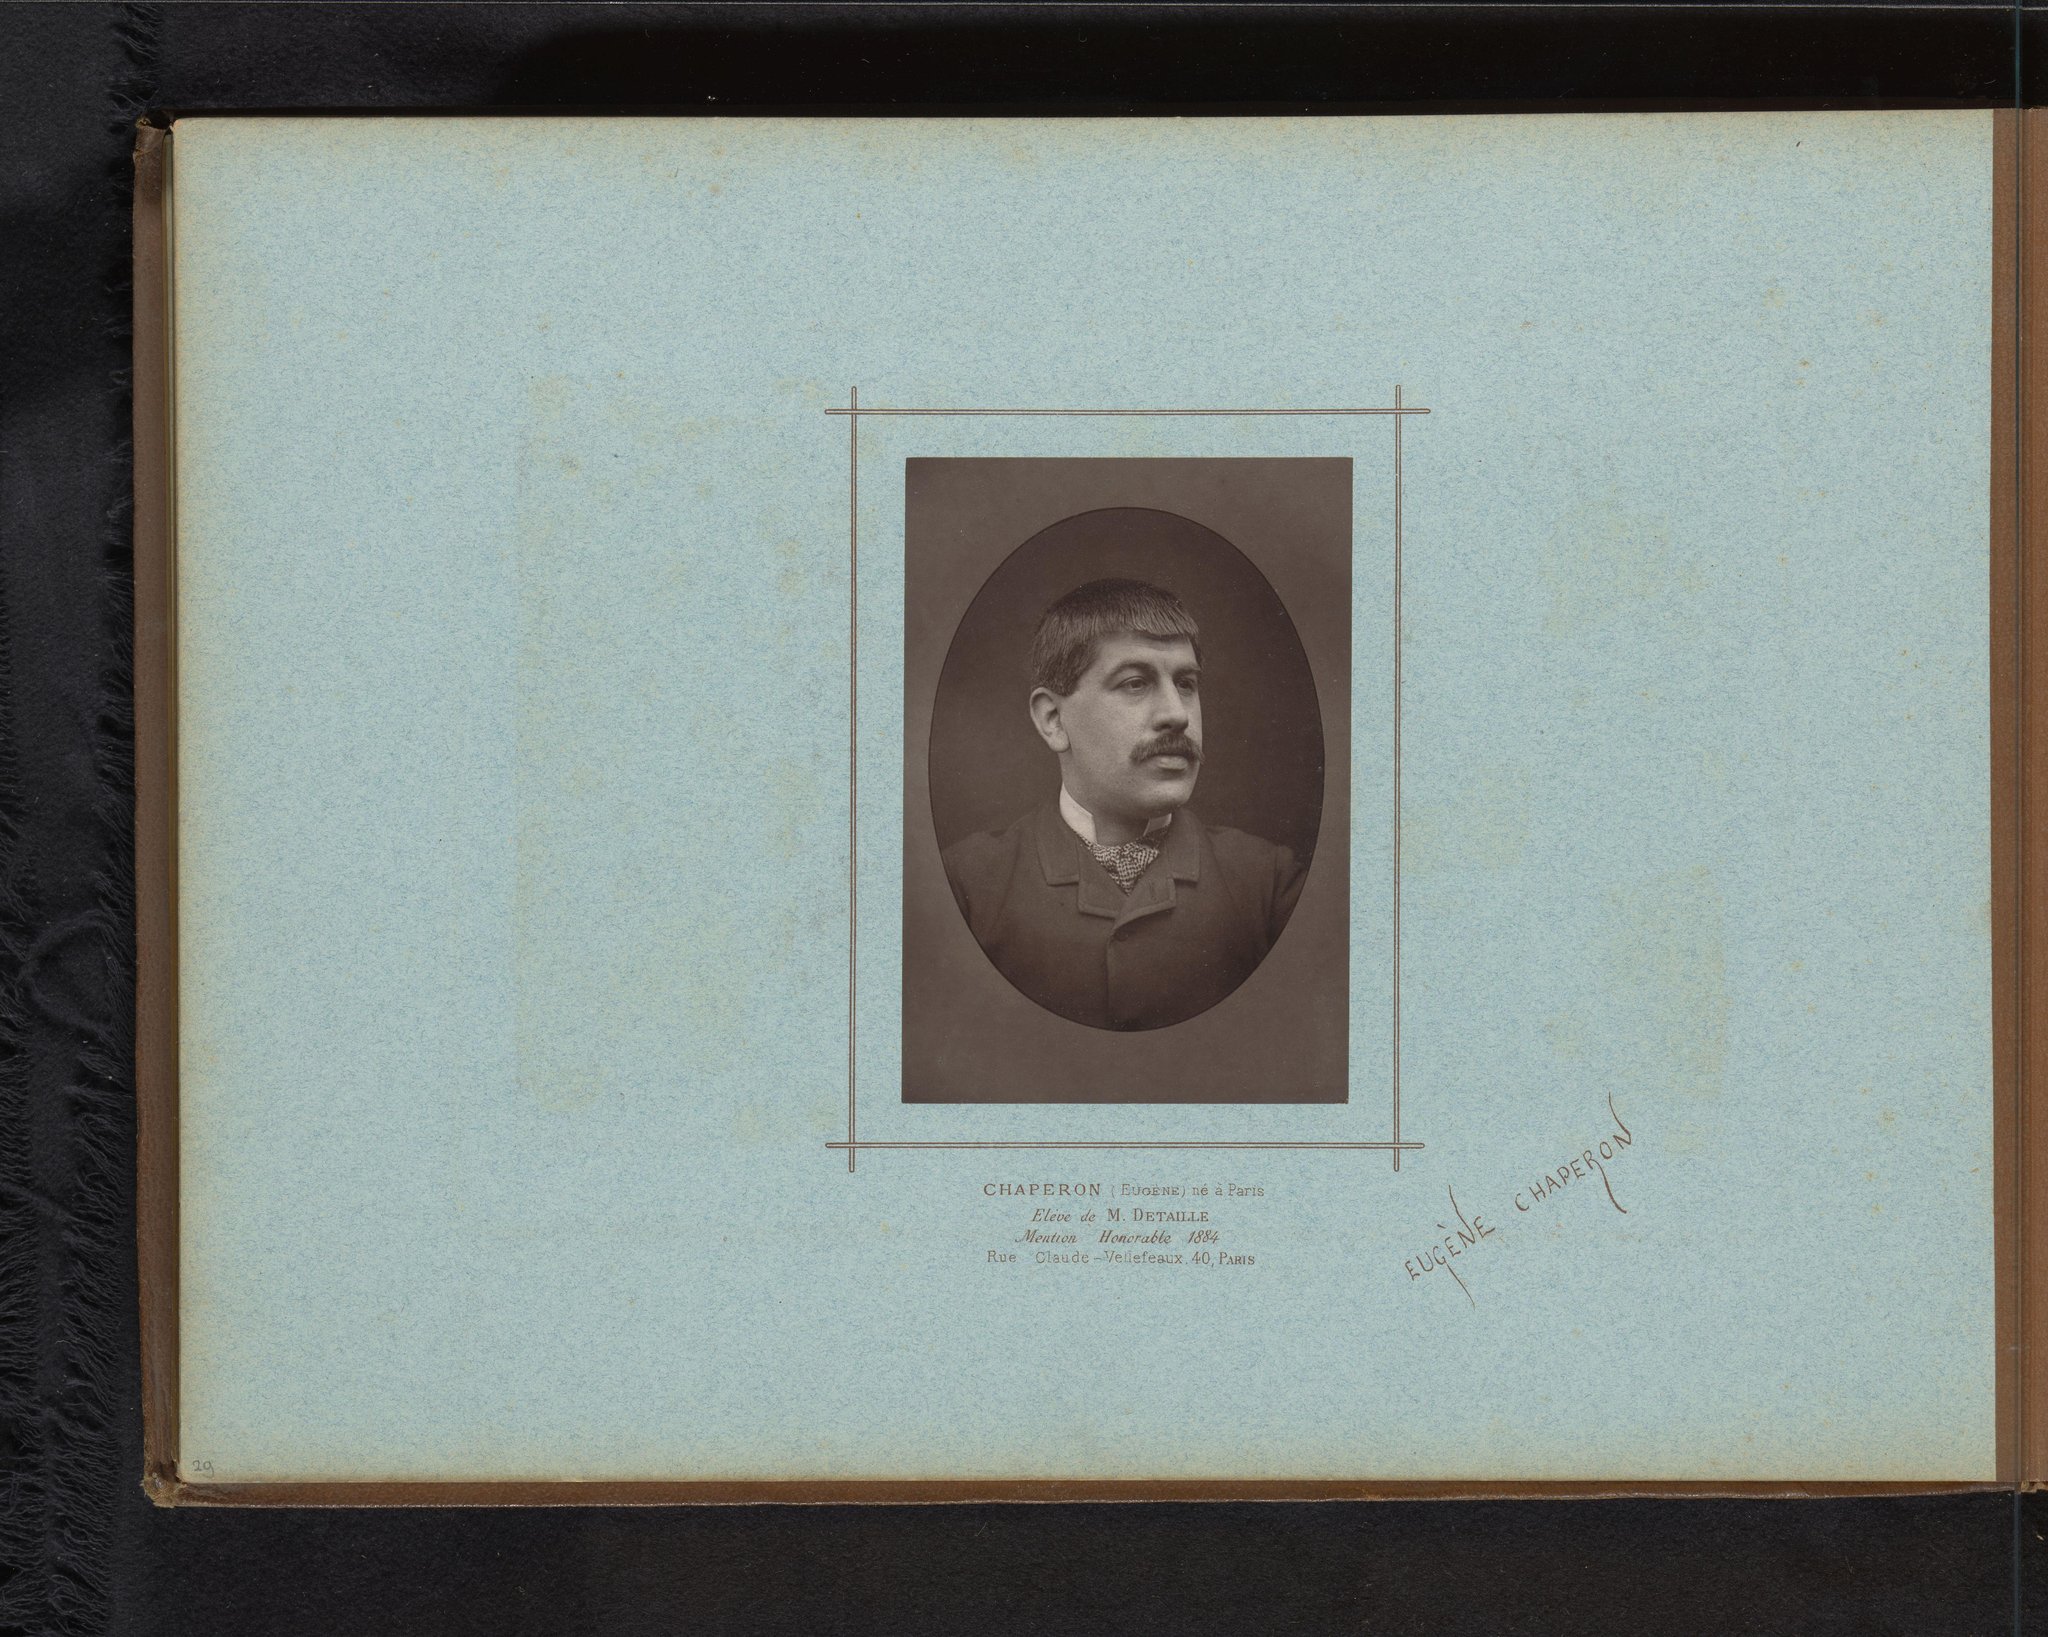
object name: page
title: Portret van Eugène Chaperon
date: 1879-1884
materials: paper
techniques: woodburytype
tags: paris, painter, designer, eugène chaperon, historical persons, portrait, self-portrait of painter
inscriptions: inscription: ‘CHAPERON (Eugène) né à Paris/ Elève de M. Detaille/ Mention Honorable 1884/ Rue Claude-Velelfeaux, 40, Paris.’, signature: ‘Eugène Chaperon’